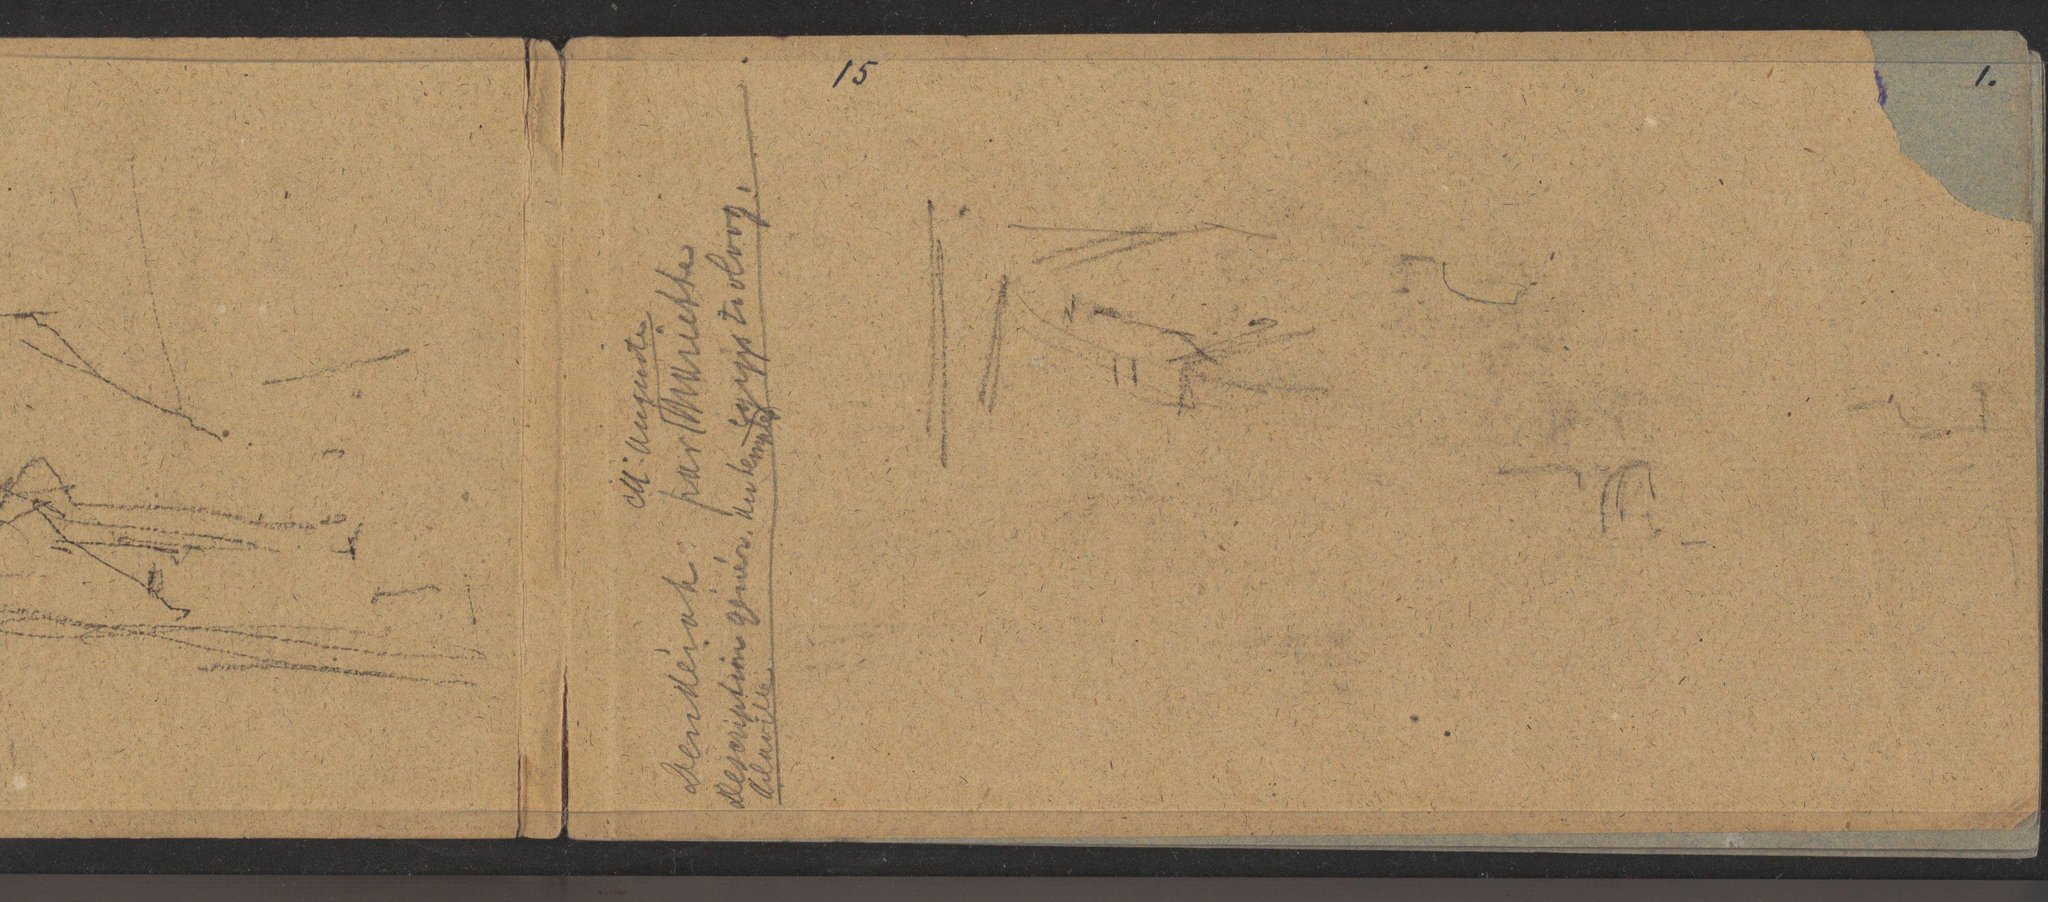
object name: sketchbook leaf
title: Studie, mogelijk van een boot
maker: george hendrik breitner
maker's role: draughtsman, painter, print maker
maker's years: 1857-1923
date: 1883-1885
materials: chalk, paper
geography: the hague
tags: ships (in general)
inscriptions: annotation: ‘Dendérah, par M Auguste Mariette/ Description Génér. du temple/ de la ville/ egyptoloog’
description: Schutblad B, vrij schutblad, uit een schetsboek met 36 bladen. Linksboven gepagineerd: 15.